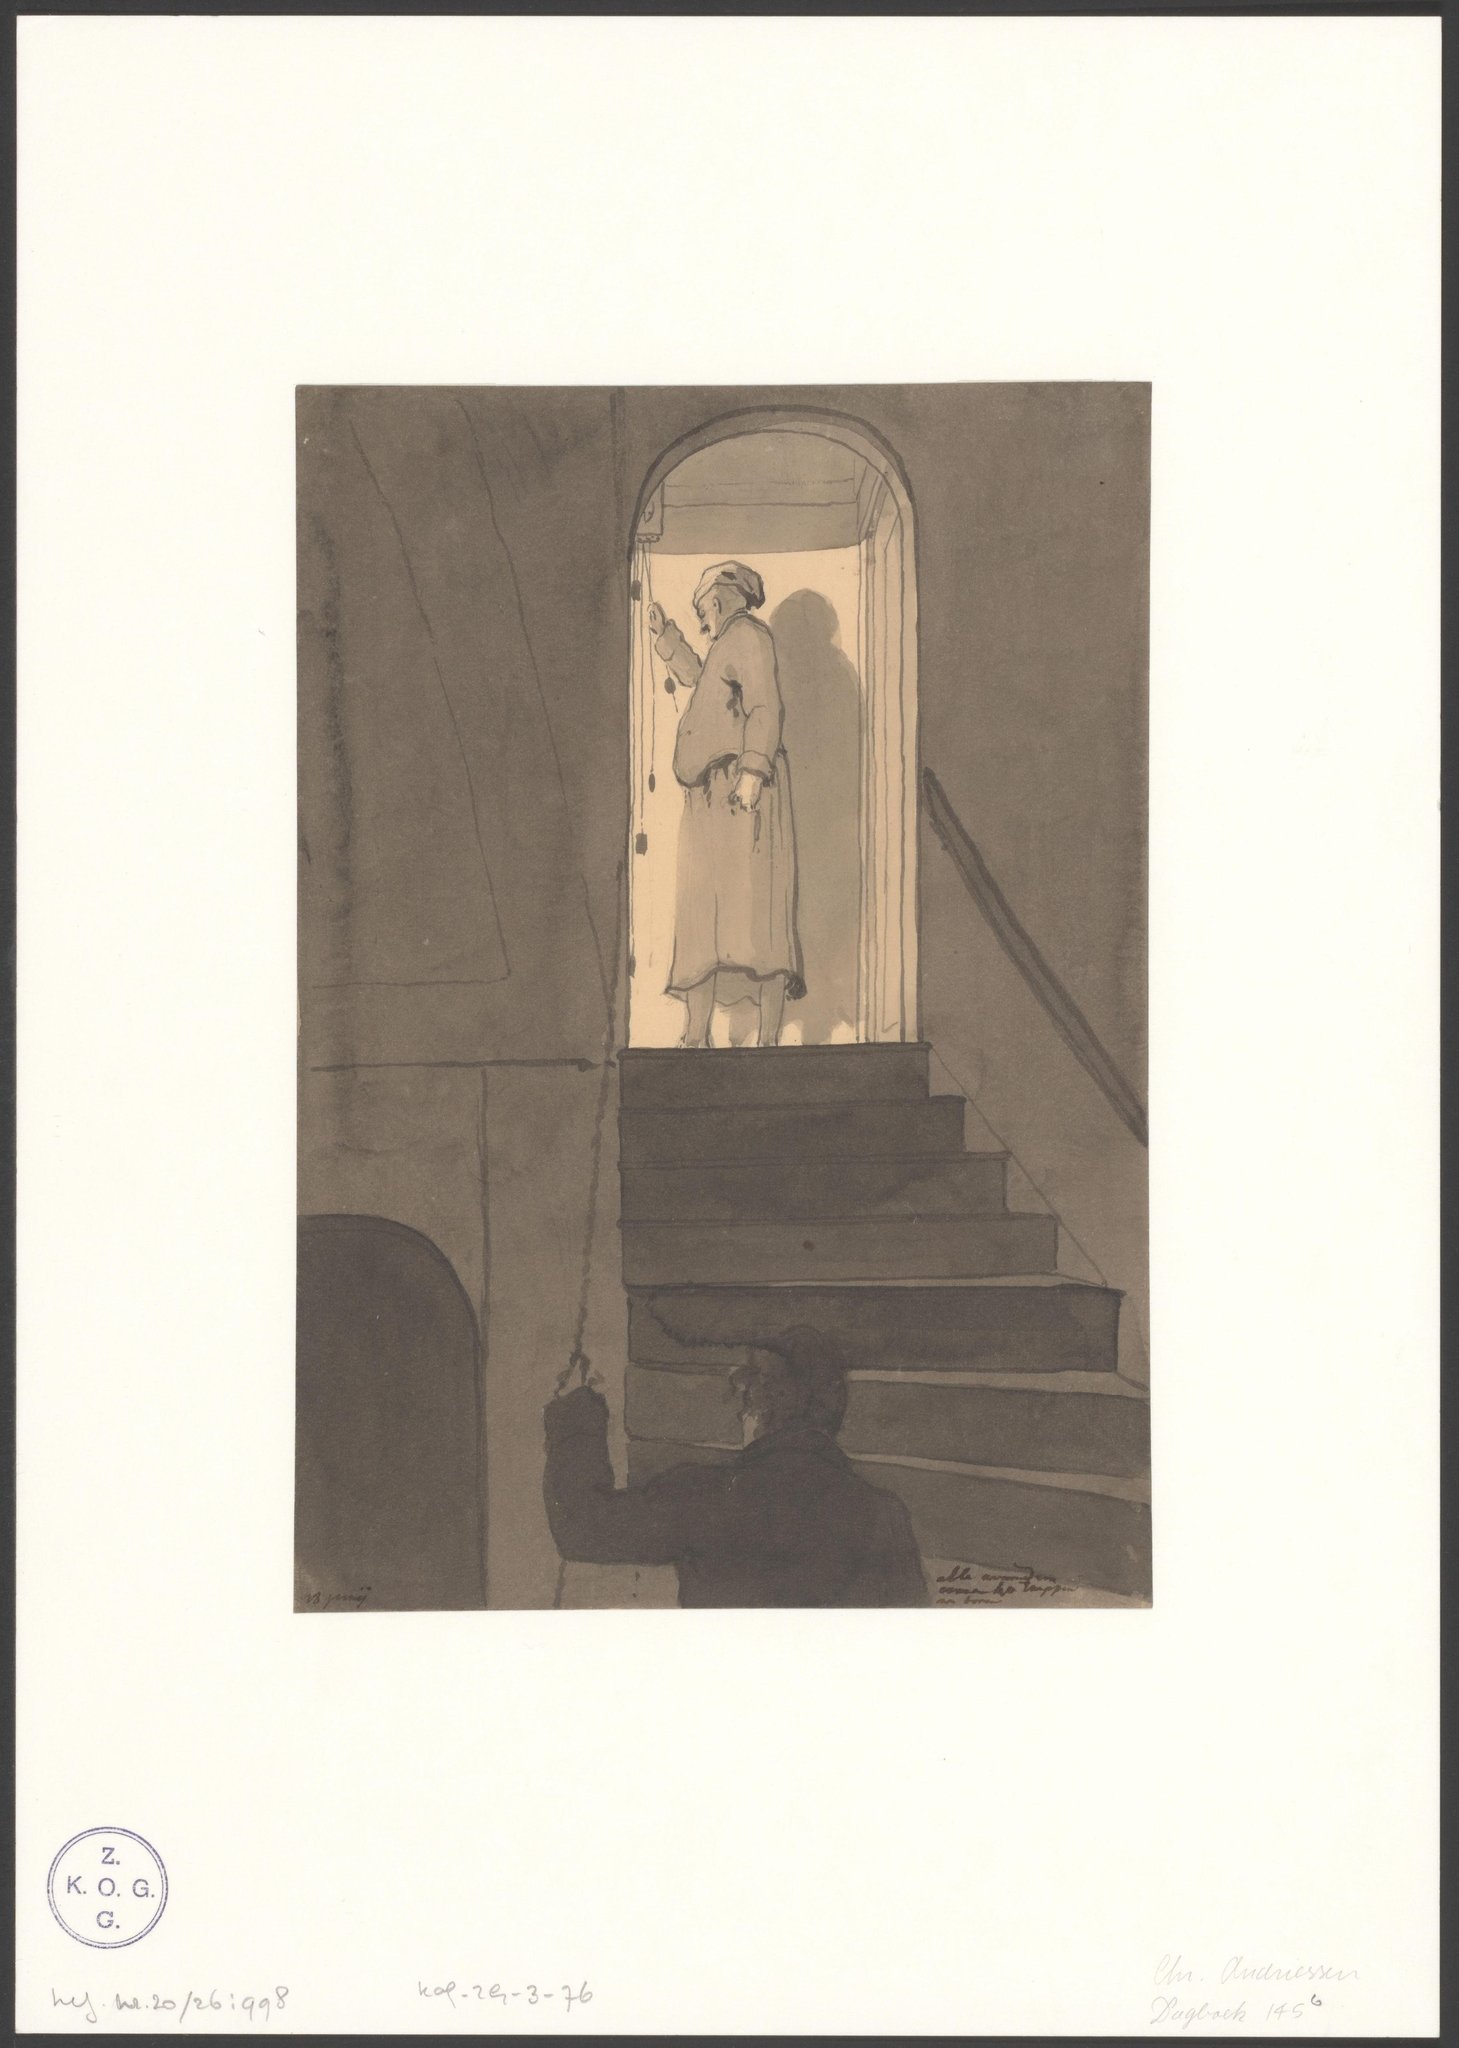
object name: drawing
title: Interieur van een gang en een man die de klok afstelt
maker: christiaan andriessen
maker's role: draughtsman, print maker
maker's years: 1775-1846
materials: ink, paper, pencil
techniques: brush, pen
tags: clock, staircase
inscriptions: inscription: ‘18 junij alle avonden (...)’, inscription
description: Dagboekblad uit het getekende dagboek dat Christiaan Andriessen bijhield van 1805 tot en met 1808.